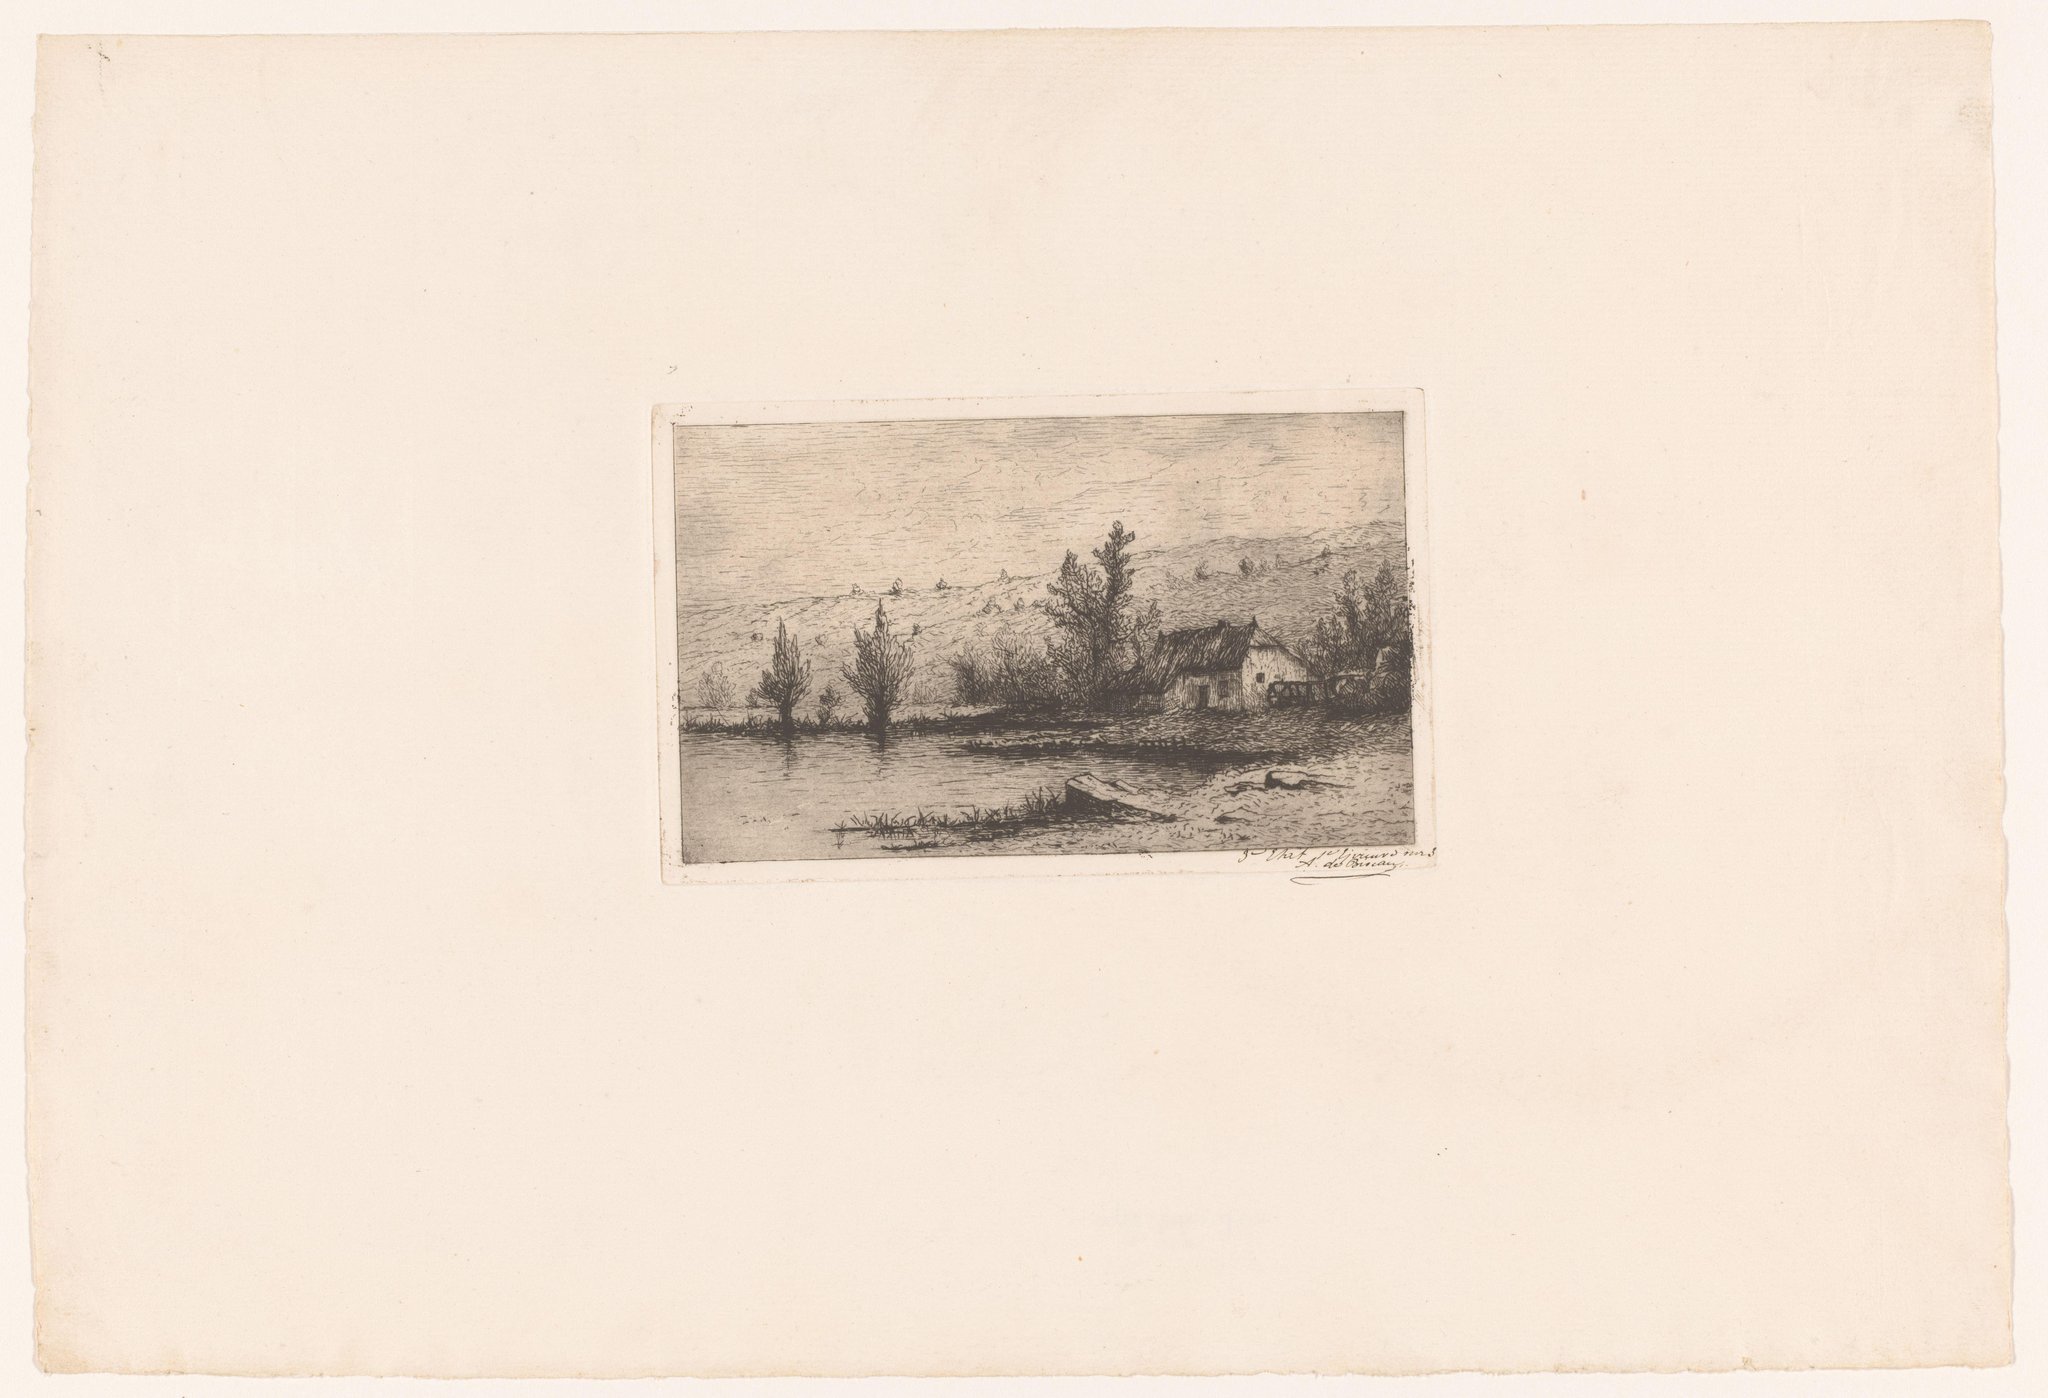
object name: print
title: Landschap met watermolen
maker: aristide de biseau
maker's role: print maker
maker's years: 1844-1883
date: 1854-1883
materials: paper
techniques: etching, intaglio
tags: watermill in landscape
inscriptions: annotation: ‘3e Etat 1e Epreuve nr 3’